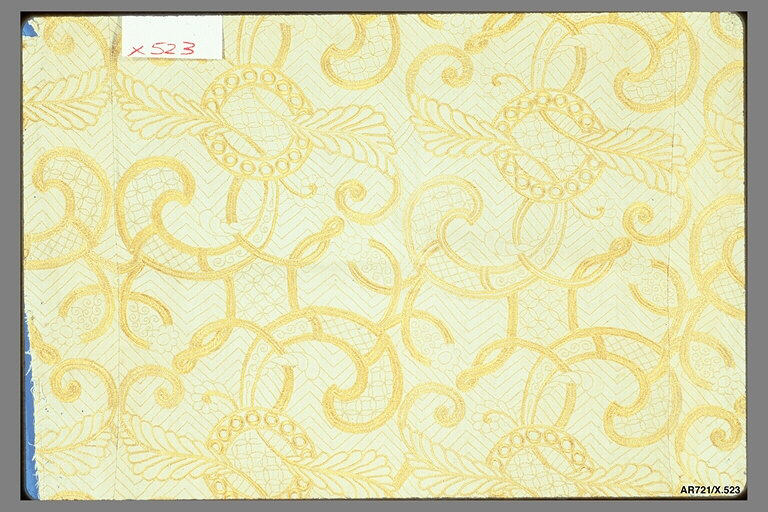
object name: piece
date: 1701-1733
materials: cotton, linen, silk